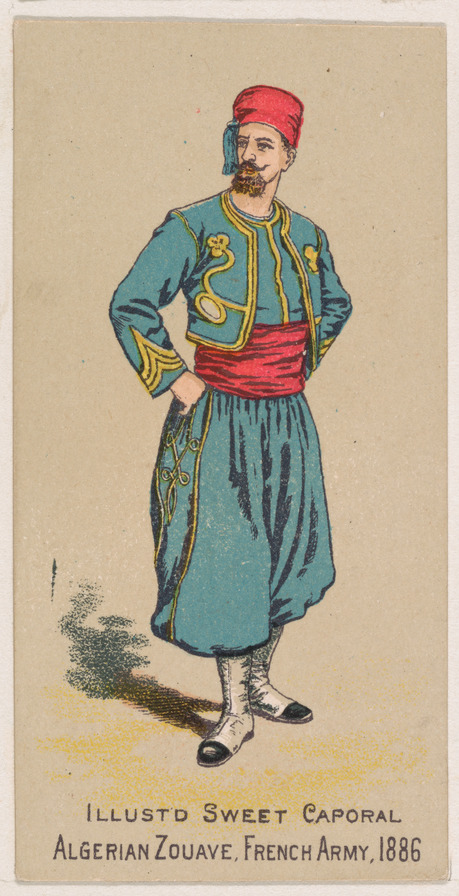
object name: print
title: Algerian Zouave, French Army, 1886, from the Military Series (N224) issued by Kinney Tobacco Company to promote Sweet Caporal Cigarettes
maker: kinney brothers tobacco company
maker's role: publisher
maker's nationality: american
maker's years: 1869-2011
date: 1888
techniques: color lithograph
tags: soldiers,men